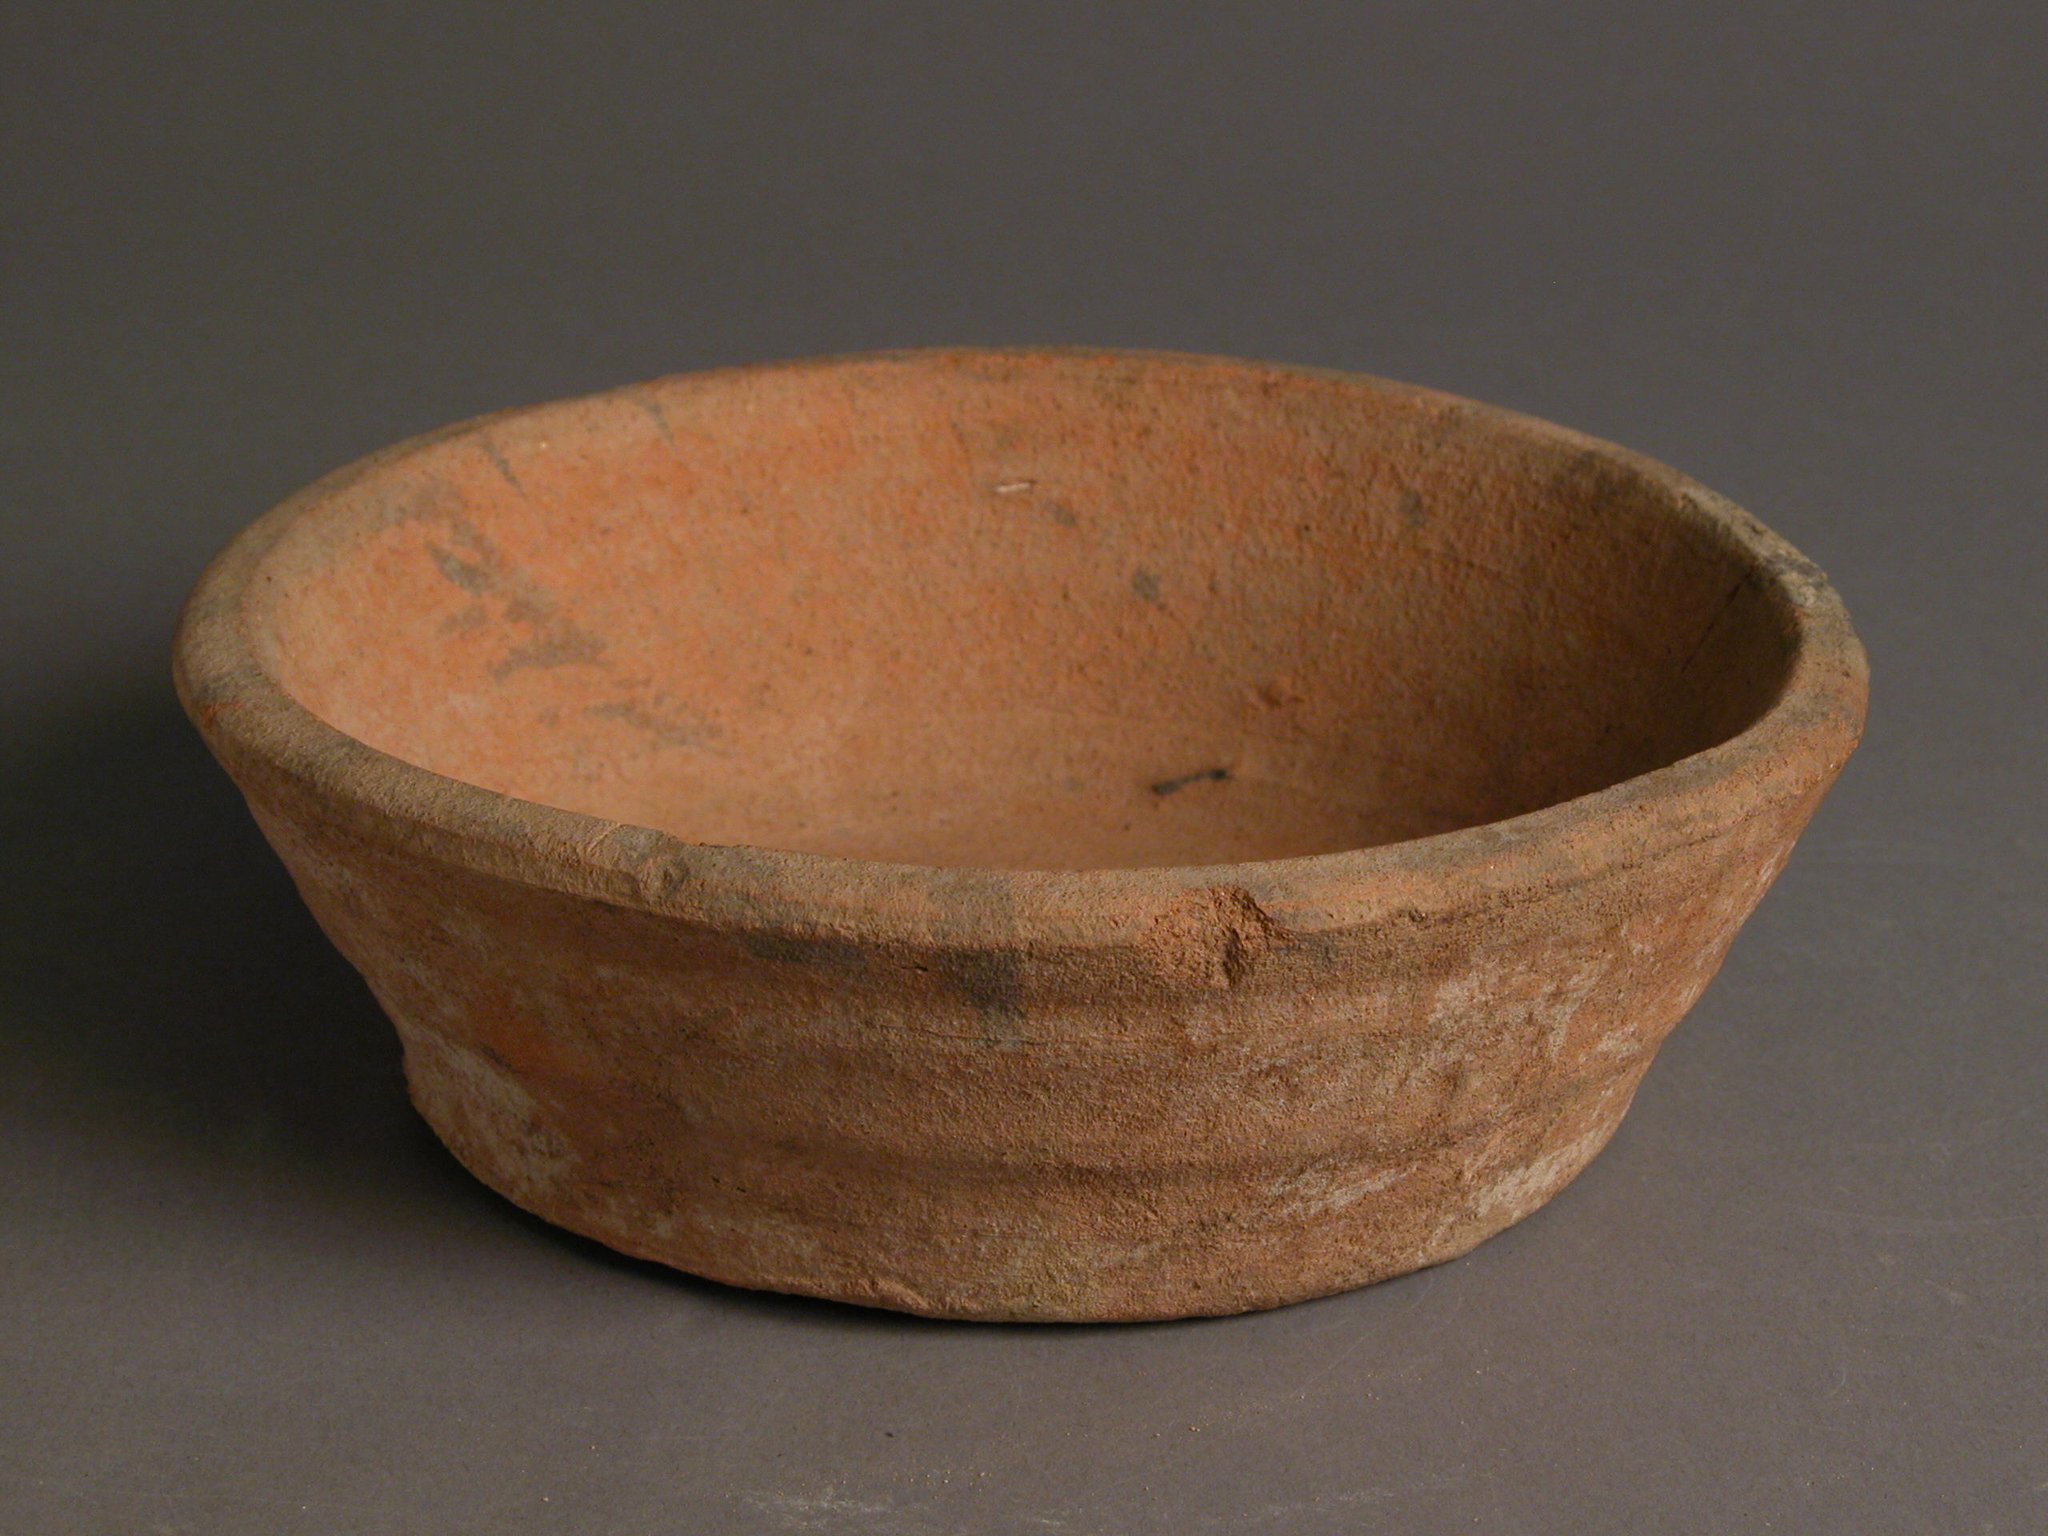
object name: bowl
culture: coptic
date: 301-700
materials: earthenware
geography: egypt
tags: bowls